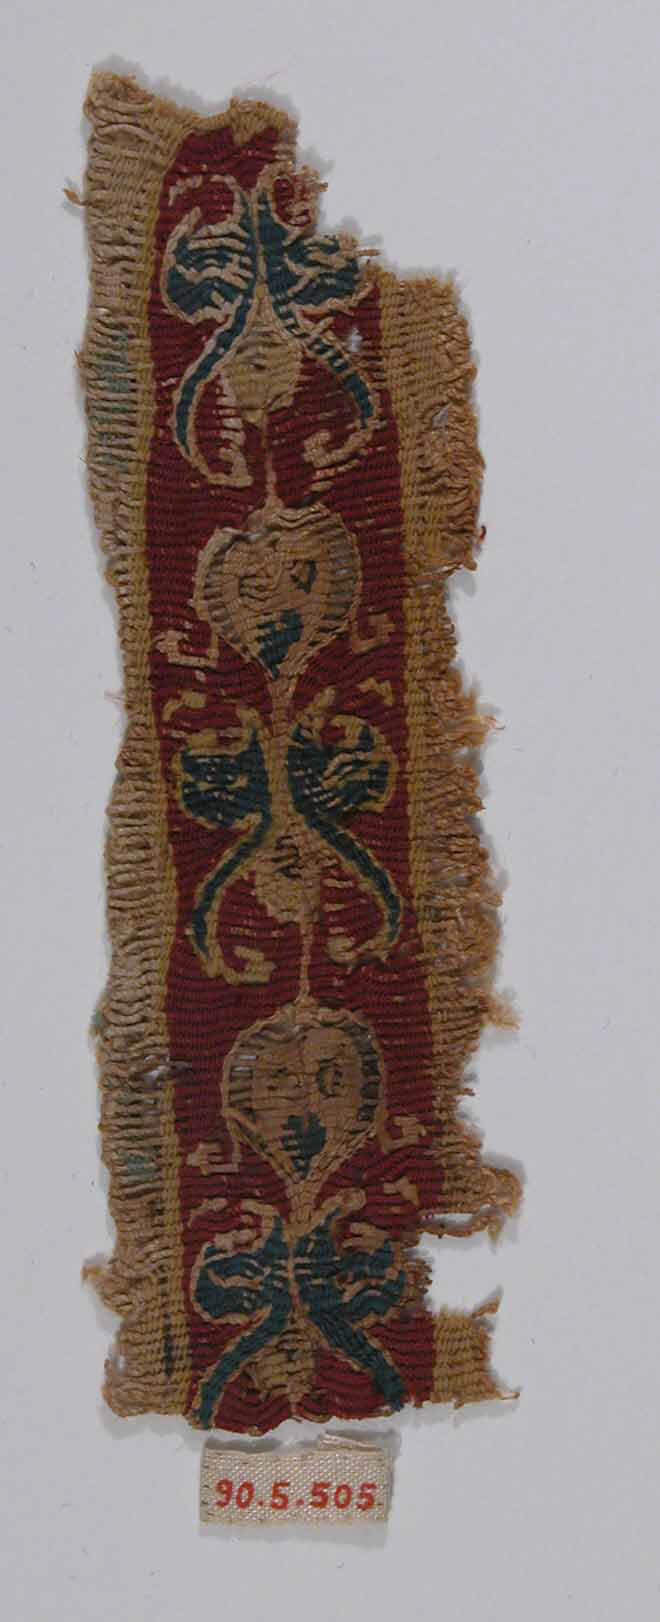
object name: textile fragment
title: Fragment of Shoulder Band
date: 501-700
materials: linen, wool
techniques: weave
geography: egypt